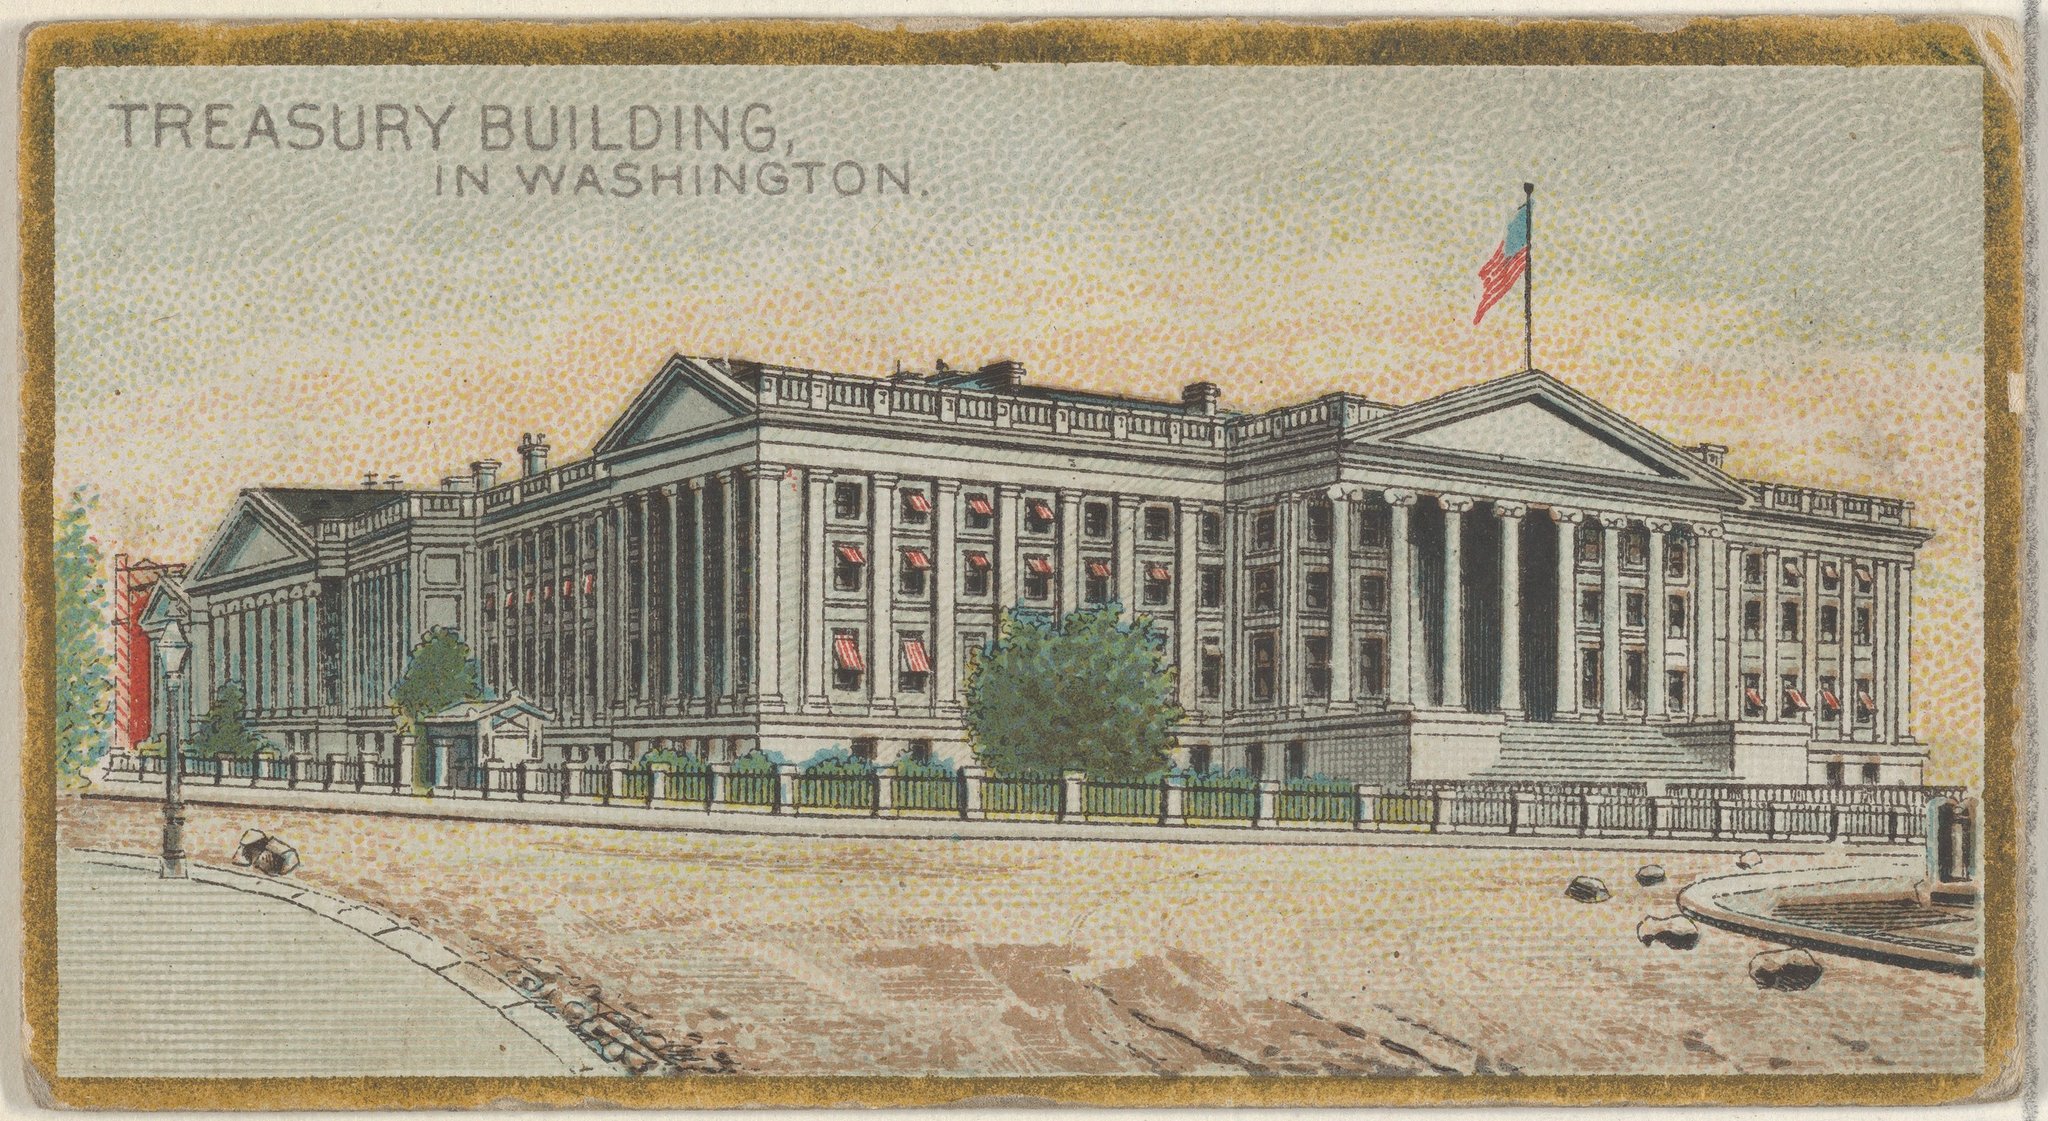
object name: print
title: Treasury Building in Washington, from the General Government and State Capitol Buildings series (N14) for Allen & Ginter Cigarettes Brands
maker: allen & ginter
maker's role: publisher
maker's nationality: american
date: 1889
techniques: color lithograph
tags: buildings